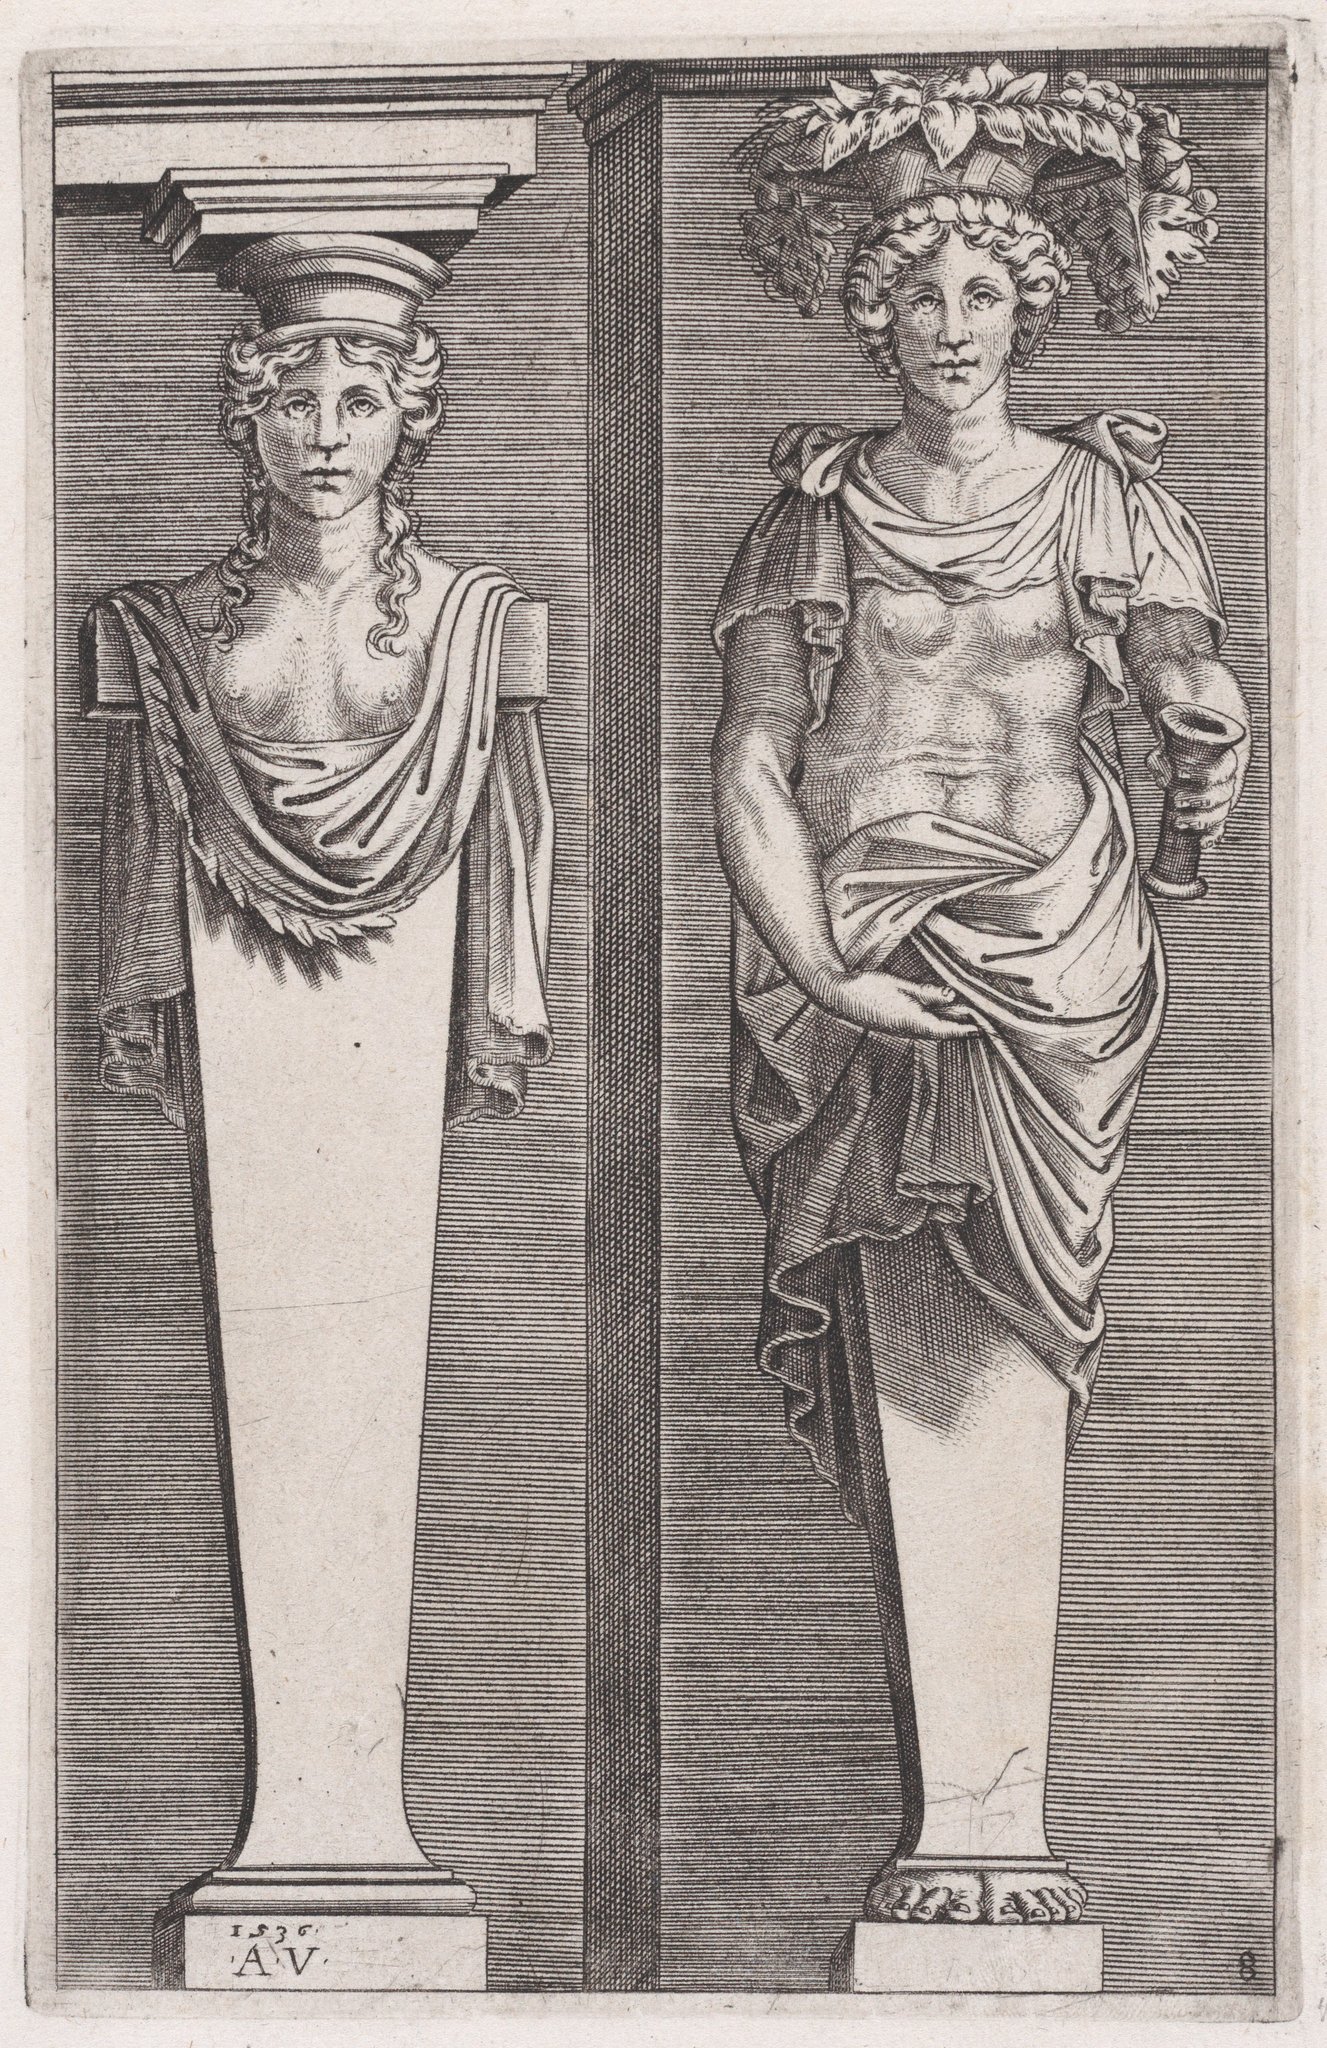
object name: print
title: Young Women, from "The Hermae"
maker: agostino veneziano (agostino dei musi)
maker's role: artist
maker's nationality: italian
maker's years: 1490-1536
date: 1536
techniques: engraving